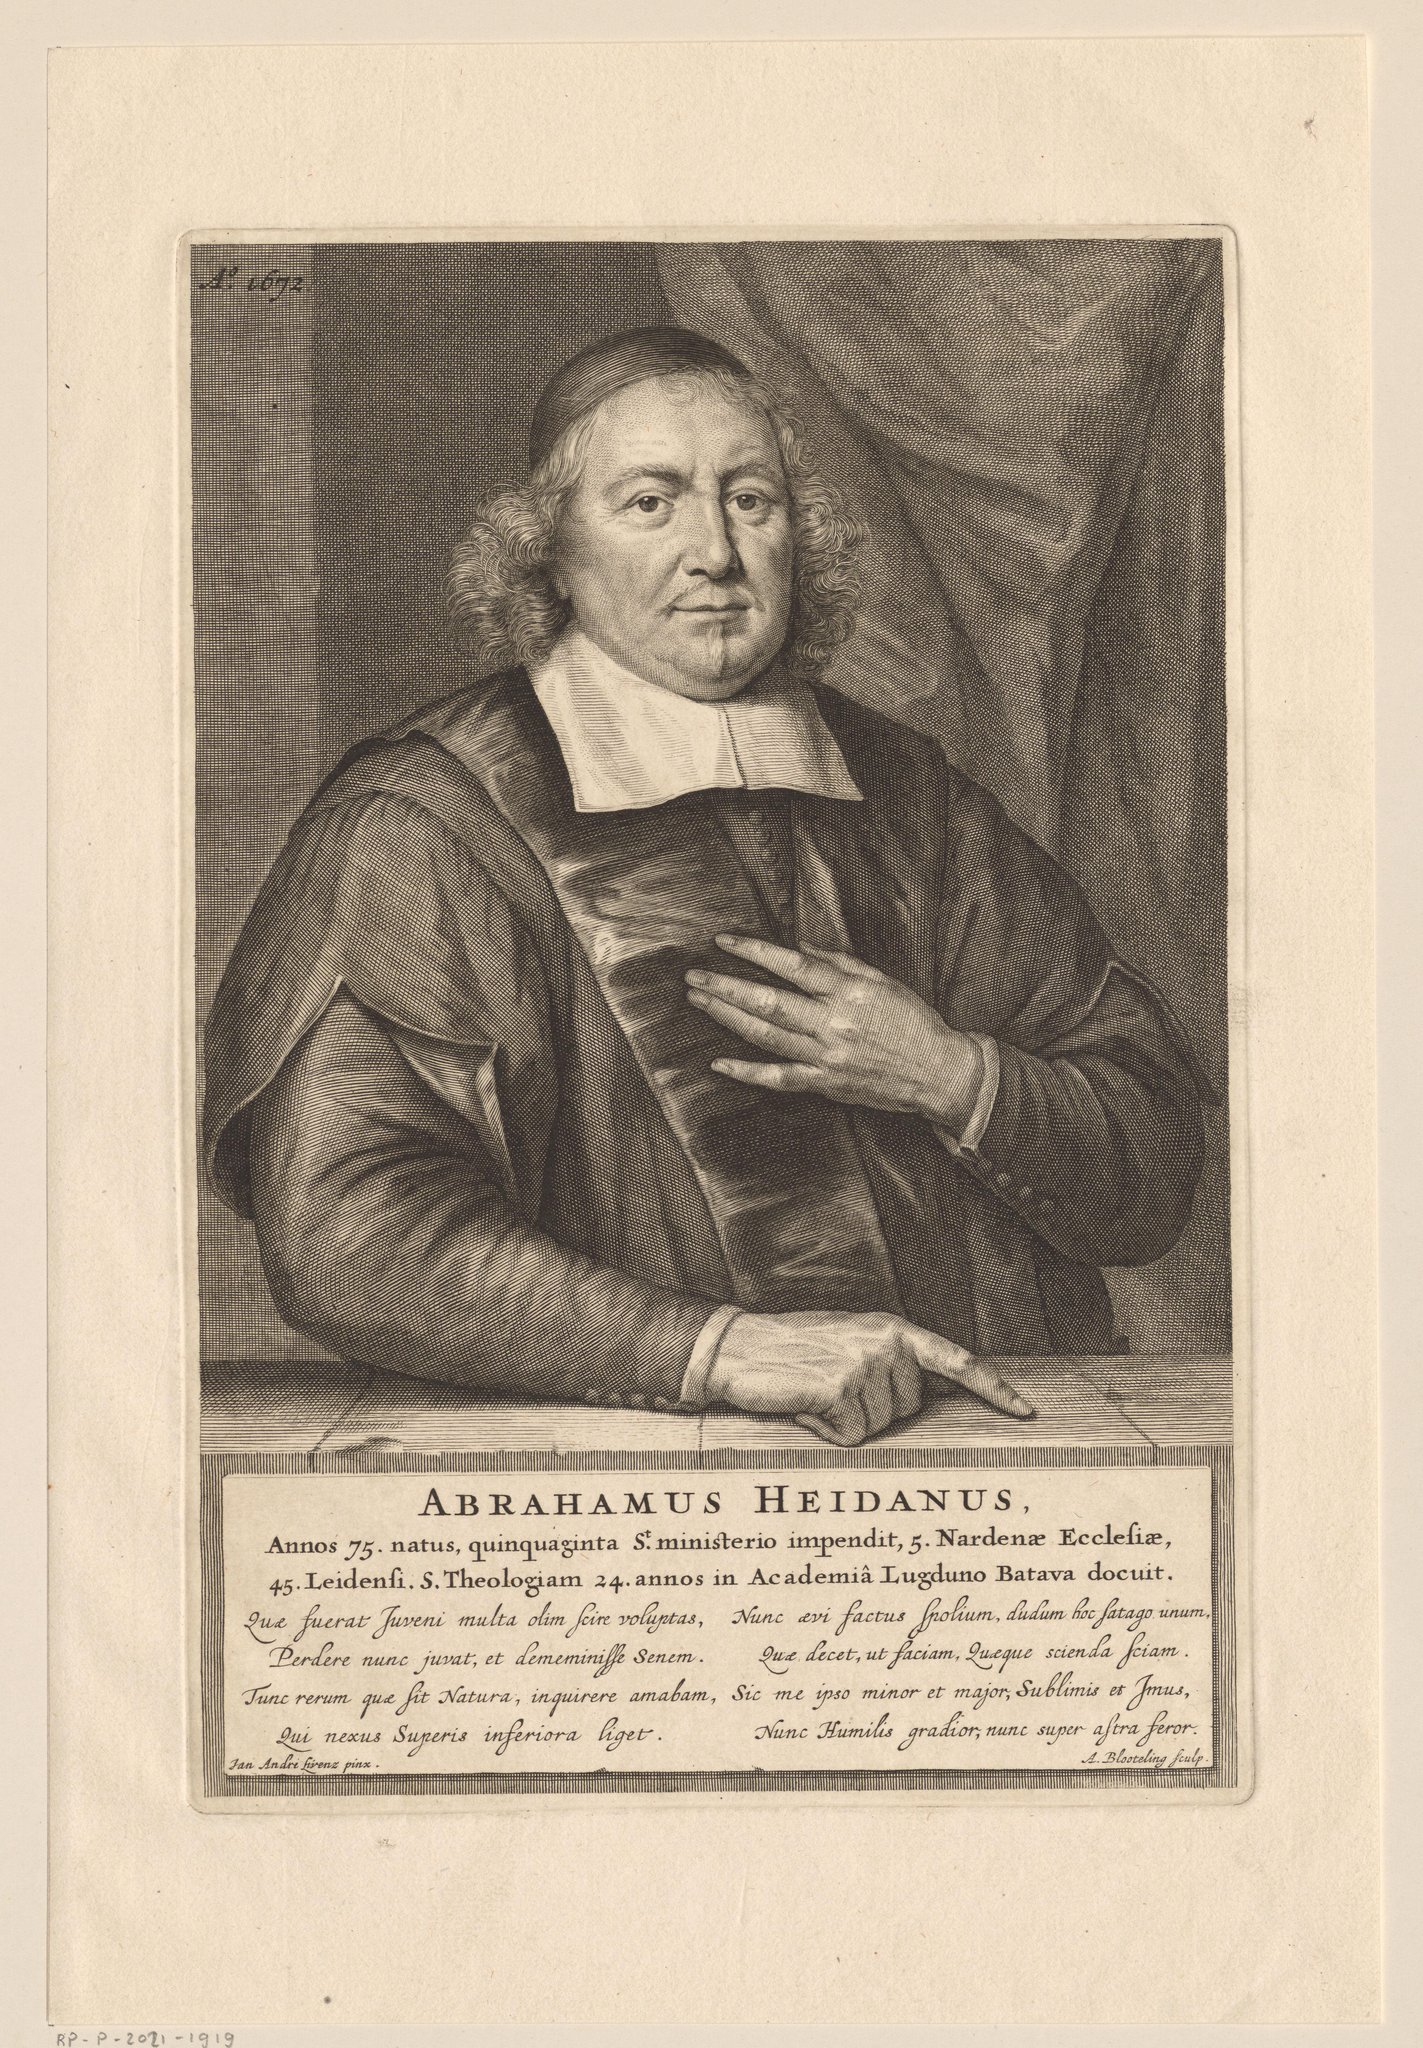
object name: print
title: Portret van Abraham Heidanus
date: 1672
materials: paper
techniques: engraving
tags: historical persons, functionaries and dignitaries ~ protestant churches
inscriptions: date